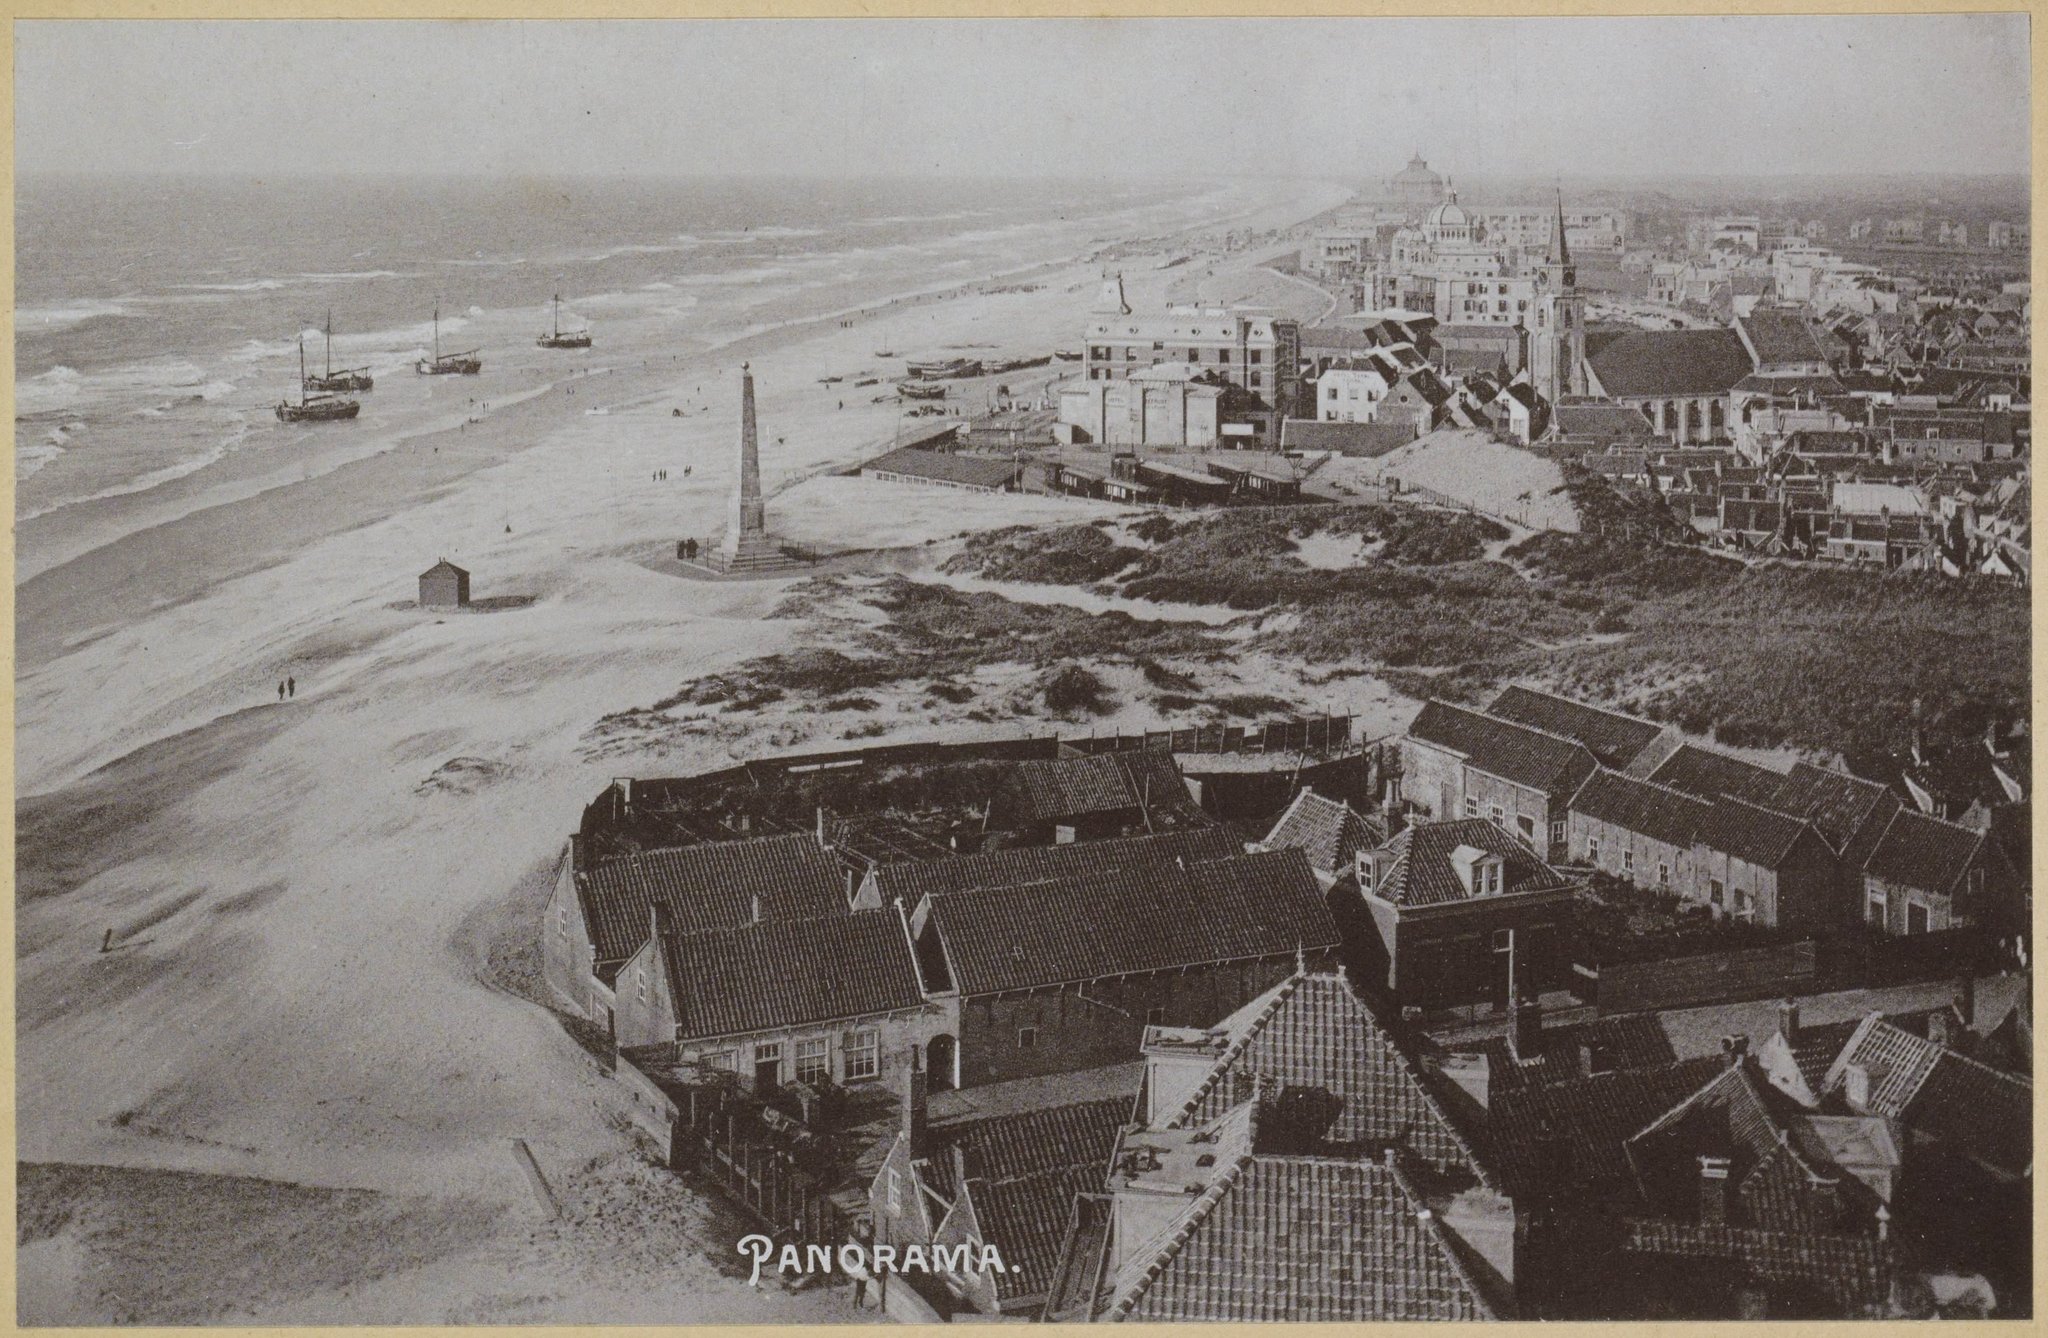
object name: photograph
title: Gezicht op Scheveningen vanuit het zuiden met links van het midden de gedenknaald voor koning Willem I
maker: Anonymous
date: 1865-1900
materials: cardboard, paper, ink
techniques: photograph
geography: scheveningen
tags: prospect of village, silhouette of village, monument, statue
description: Onderdeel van Leporelloalbum met opnames van Scheveningen.